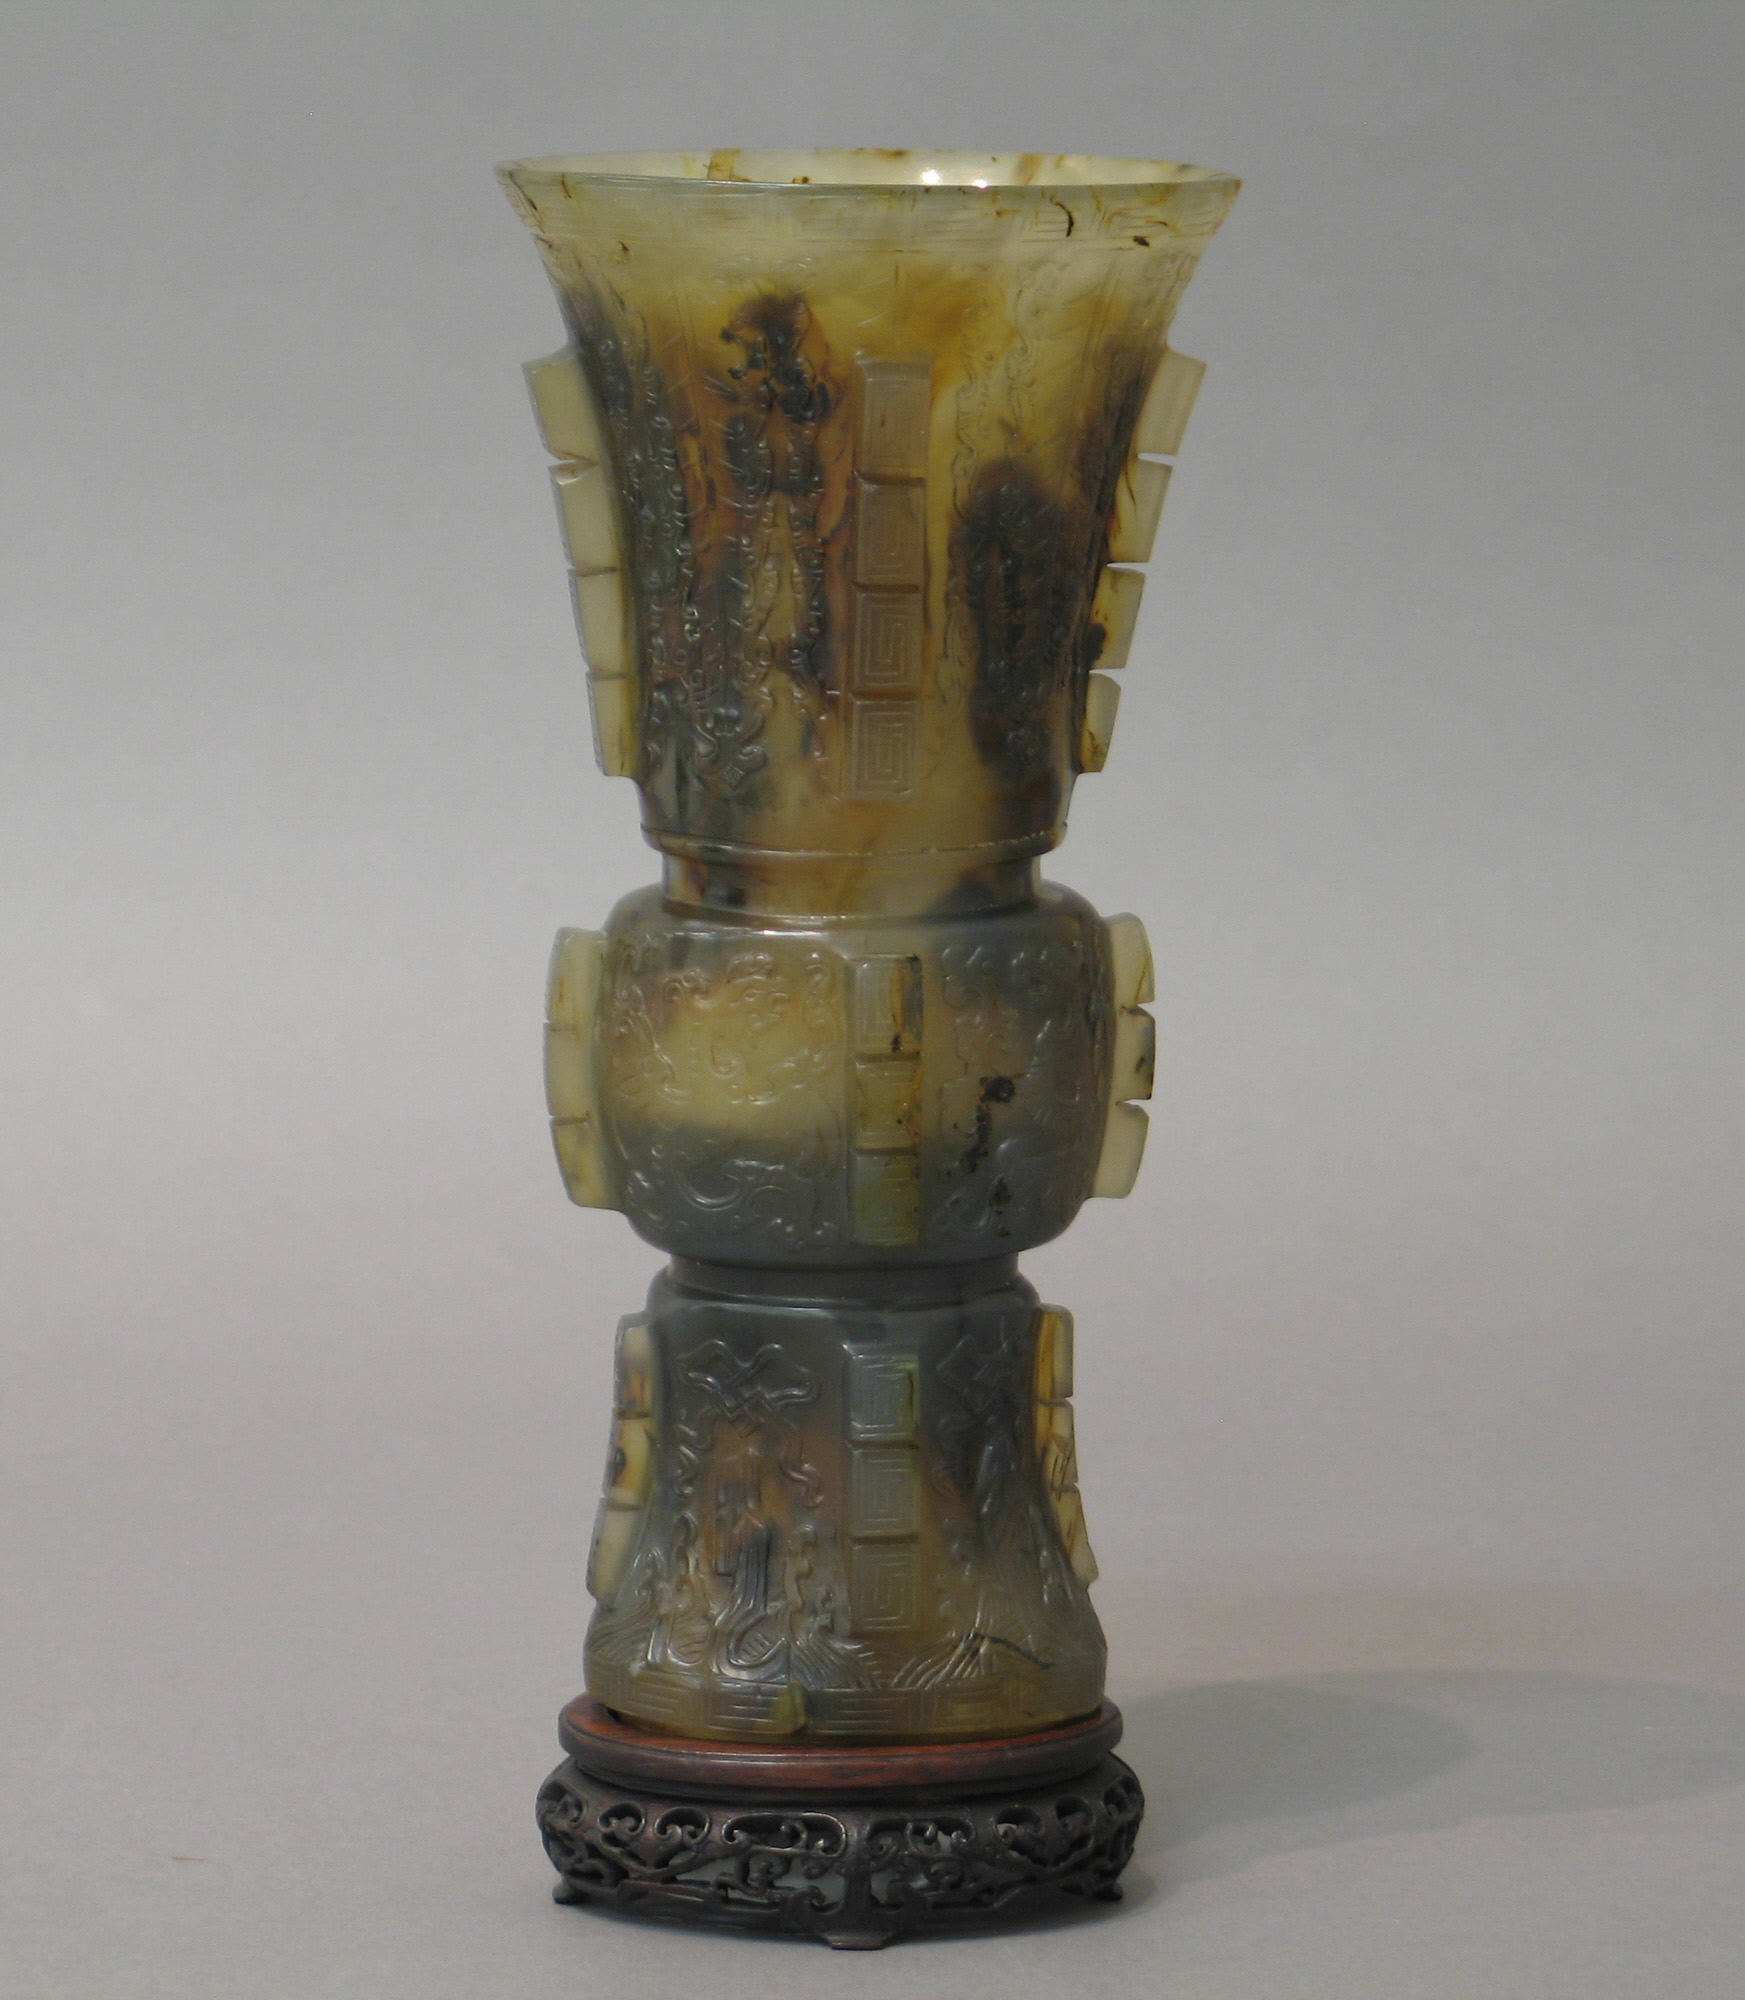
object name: beaker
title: Beaker of Archaistic Design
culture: chinese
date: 1701-1800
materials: stone